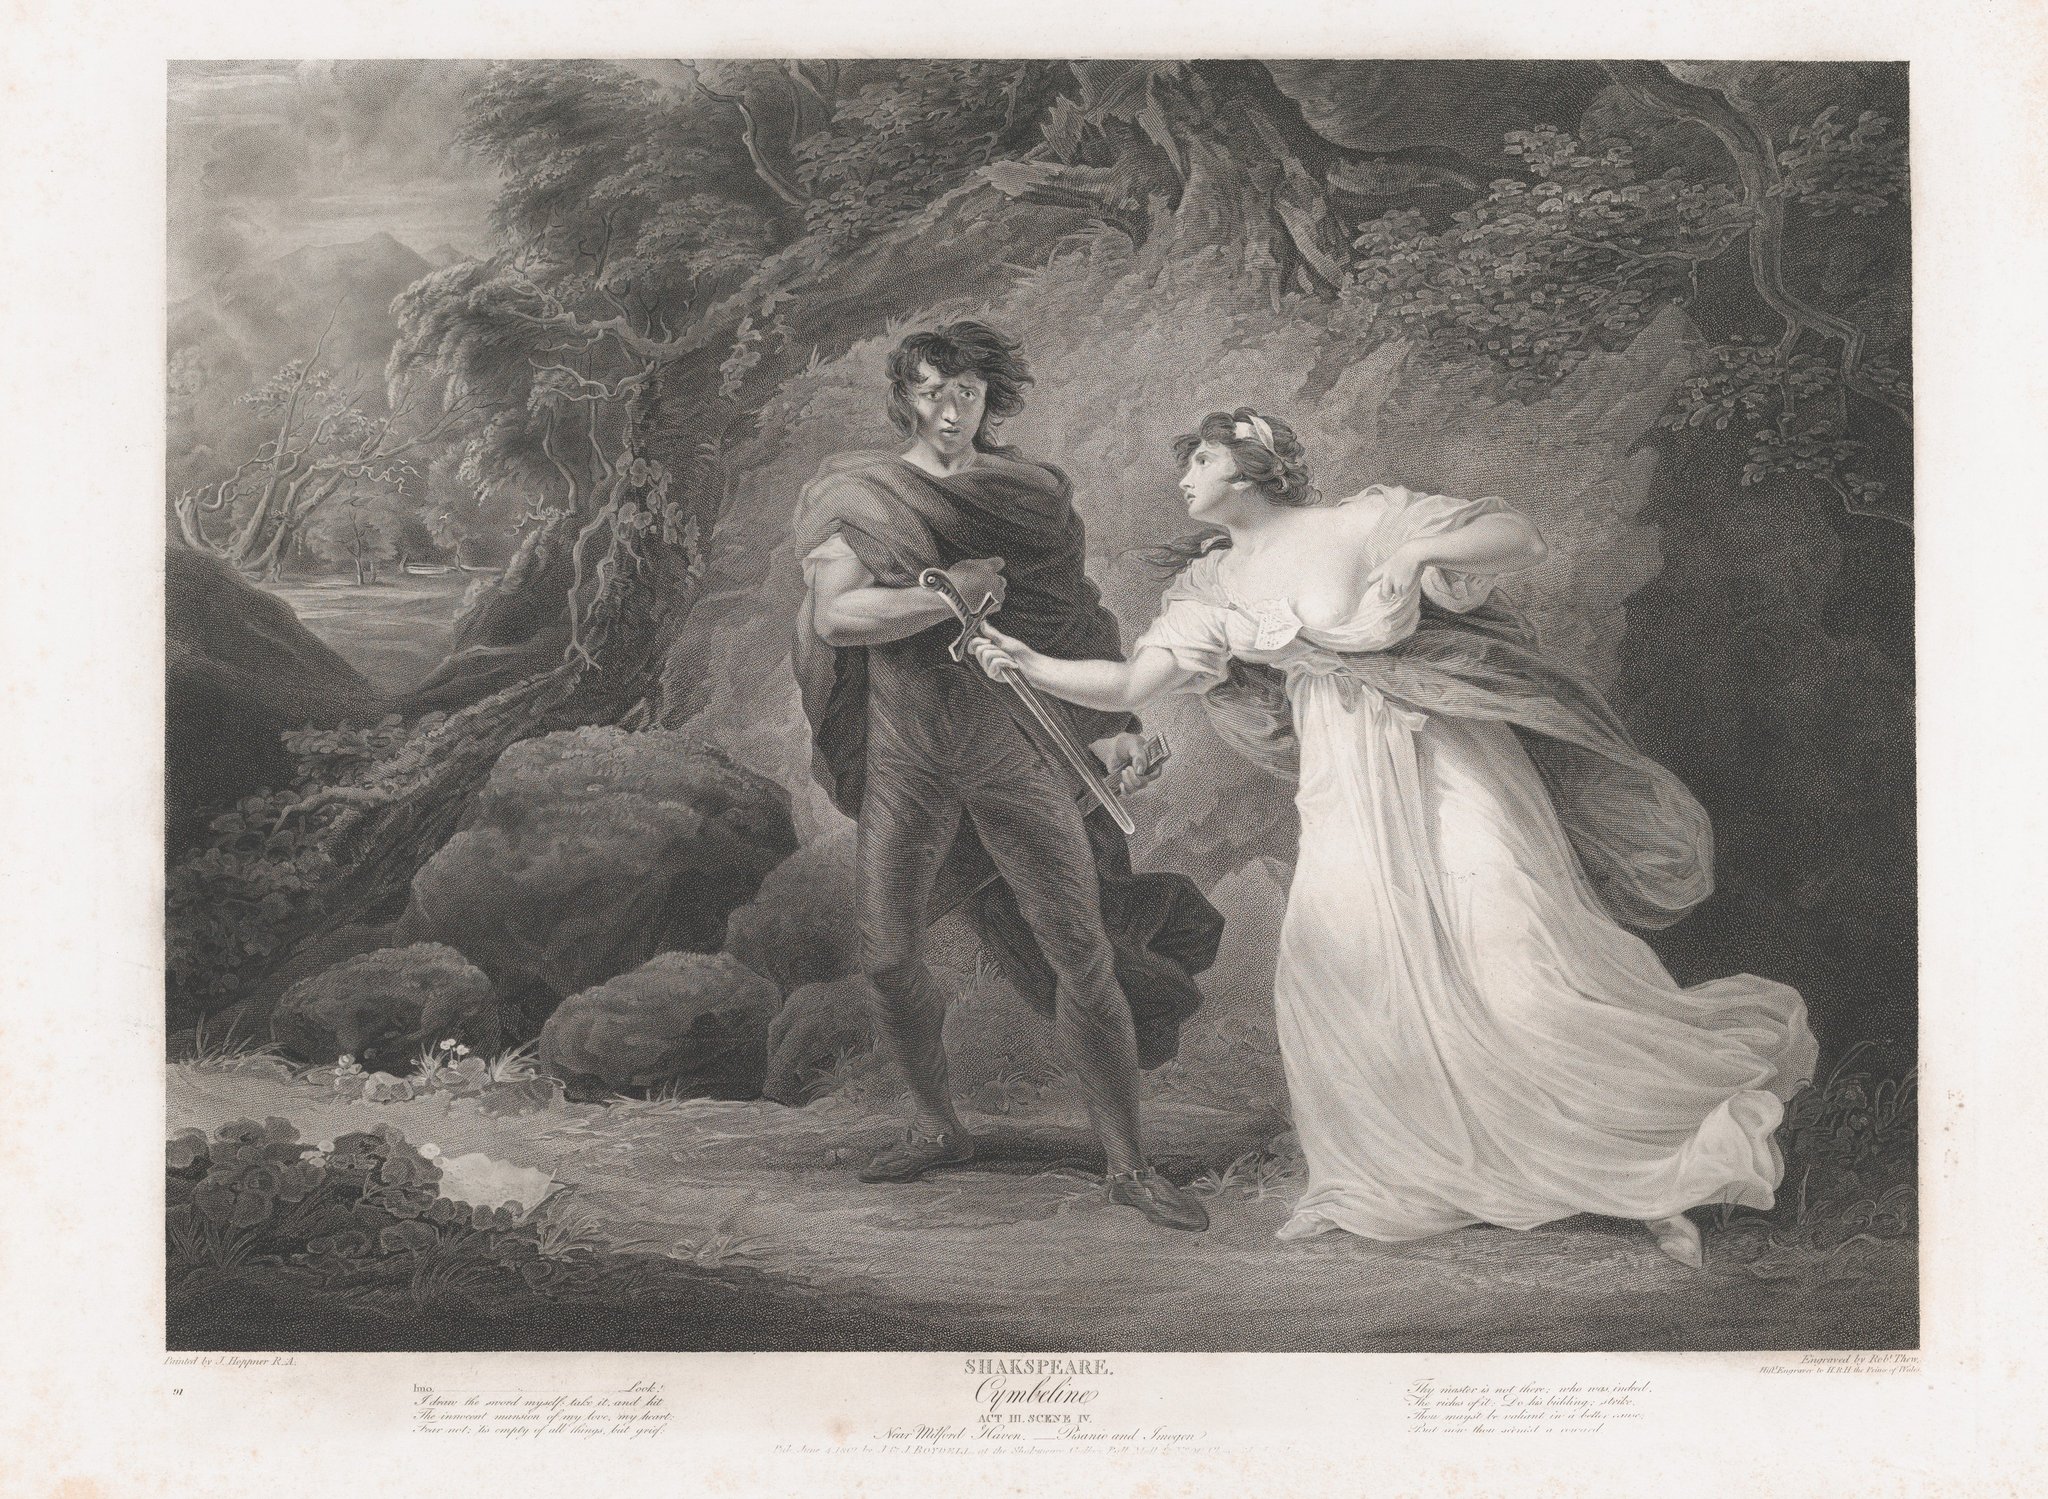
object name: print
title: Pisanio and Imogen (Shakespeare, Cymbeline, Act 3, Scene 4)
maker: robert thew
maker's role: engraver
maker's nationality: british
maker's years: 1758-1802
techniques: etching, stippling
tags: shakespeare,men,women